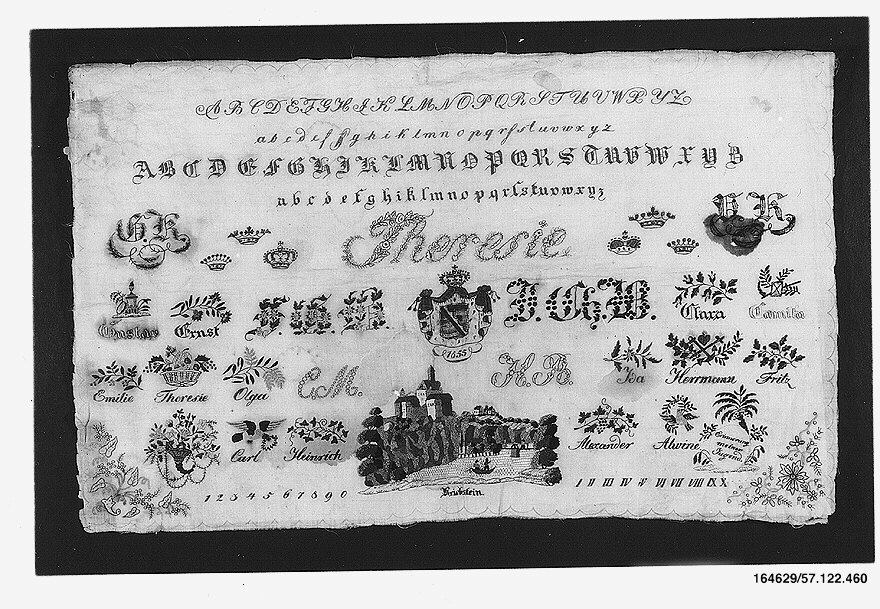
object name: sampler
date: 1855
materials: cotton, linen, metal thread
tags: birds,coat of arms